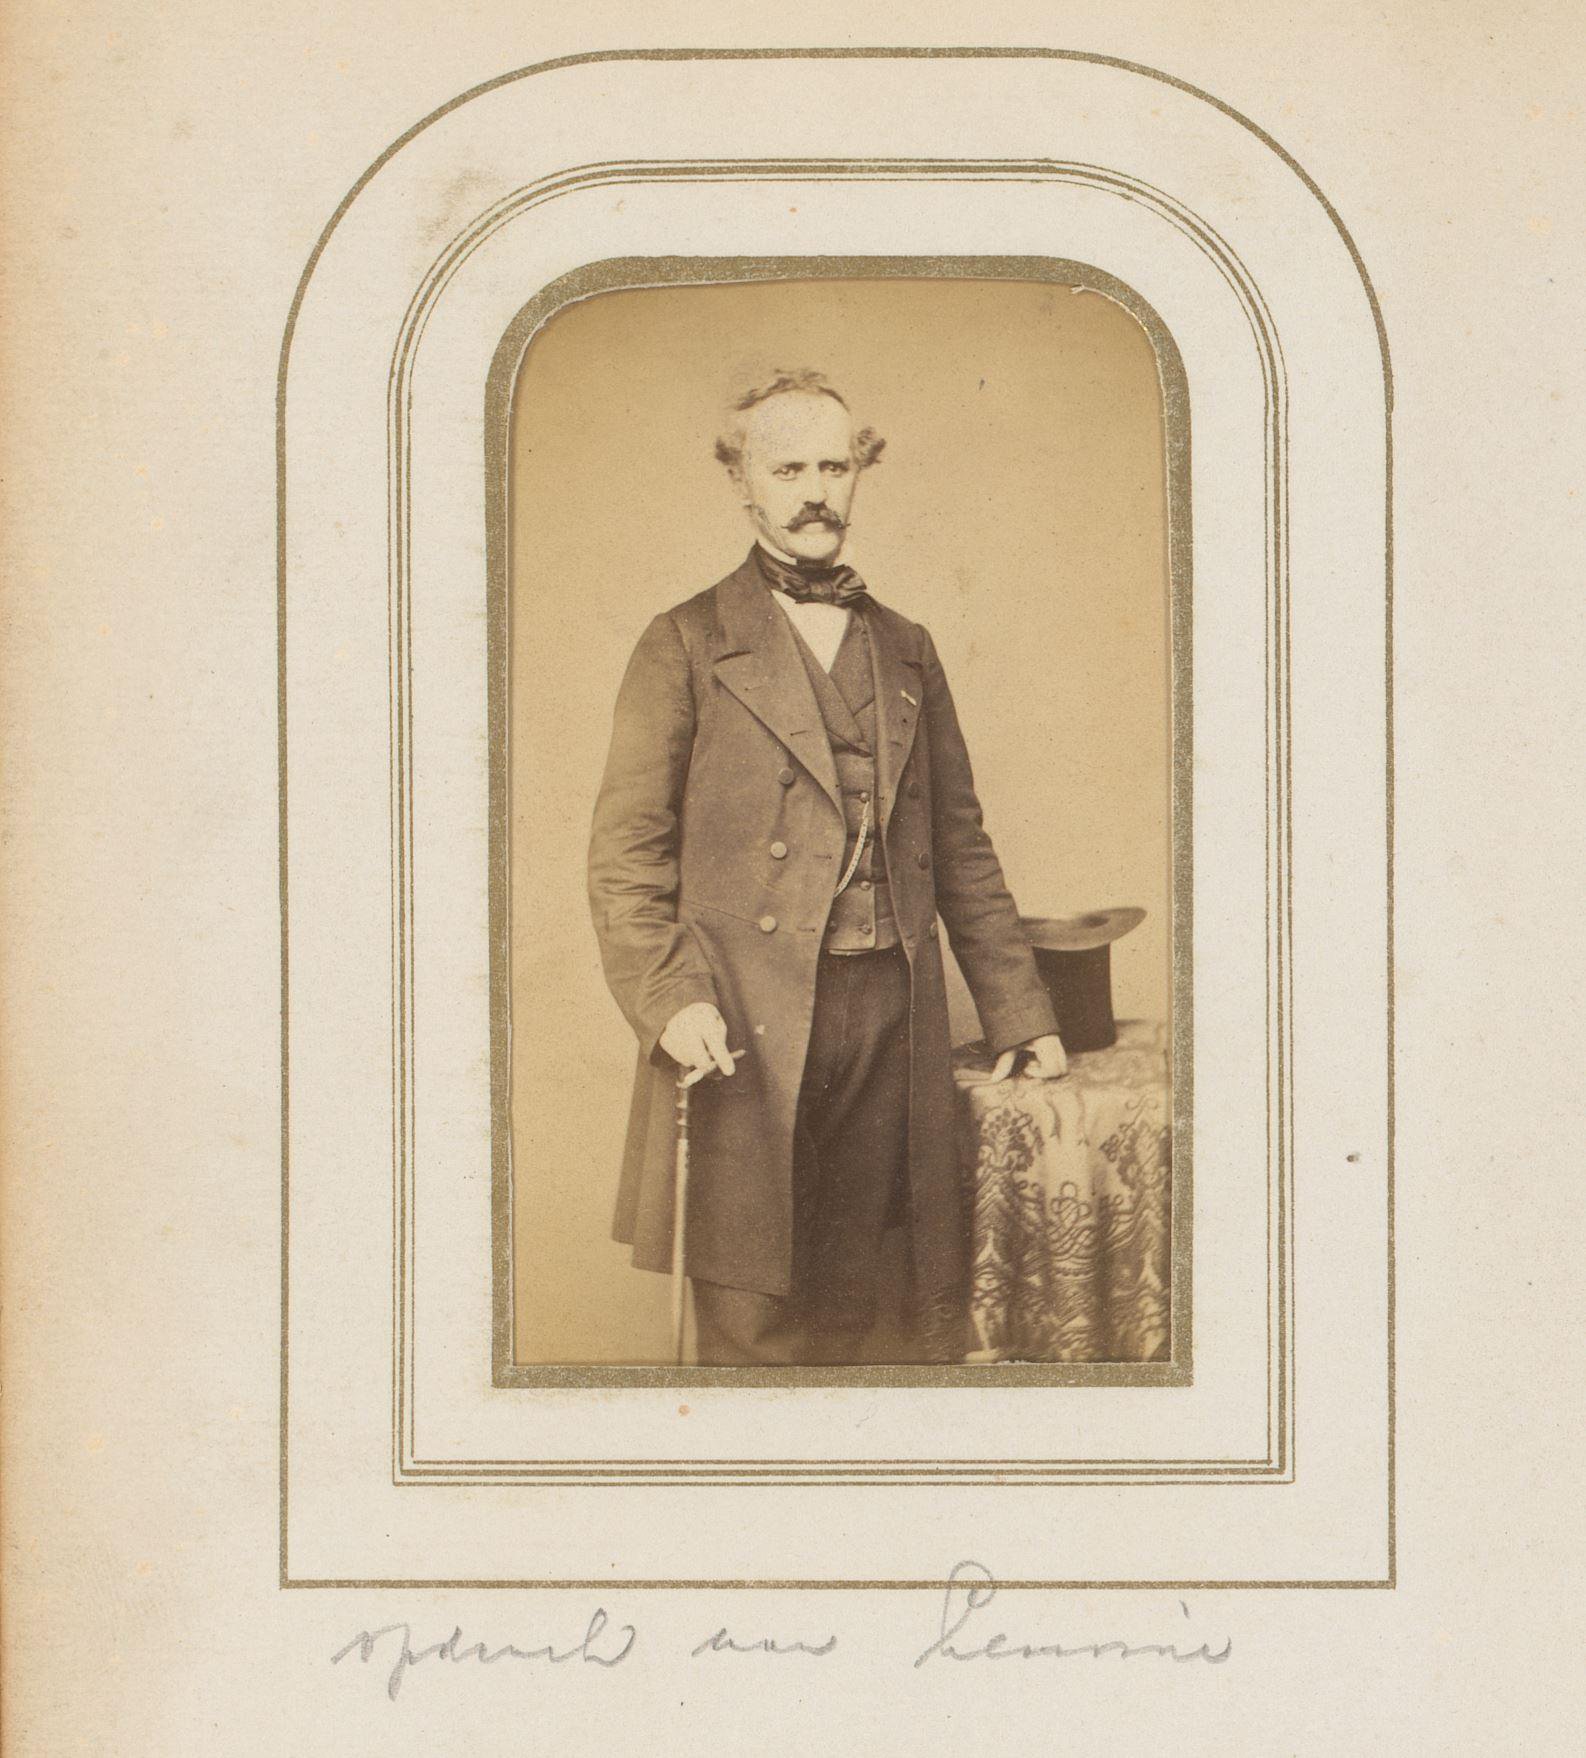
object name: photograph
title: Portret van een man met wandelstok, staand bij een tafel met hoge hoed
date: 1860-1872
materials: cardboard, photographic support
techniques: albumen print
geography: brussels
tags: walking-stick, staff, historical persons, head-gear: top hat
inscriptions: annotation: ‘opdracht aan Lemoine’, annotation: ‘Souvenir de bonne/ amitié ou camarade/ Lemoine/ [...]’, inscription: ‘Photographe Allemande/ de Chs Billotte et Cie/ Place de la Monnaie, 9 Rue de la Reine/ Bruxelles’